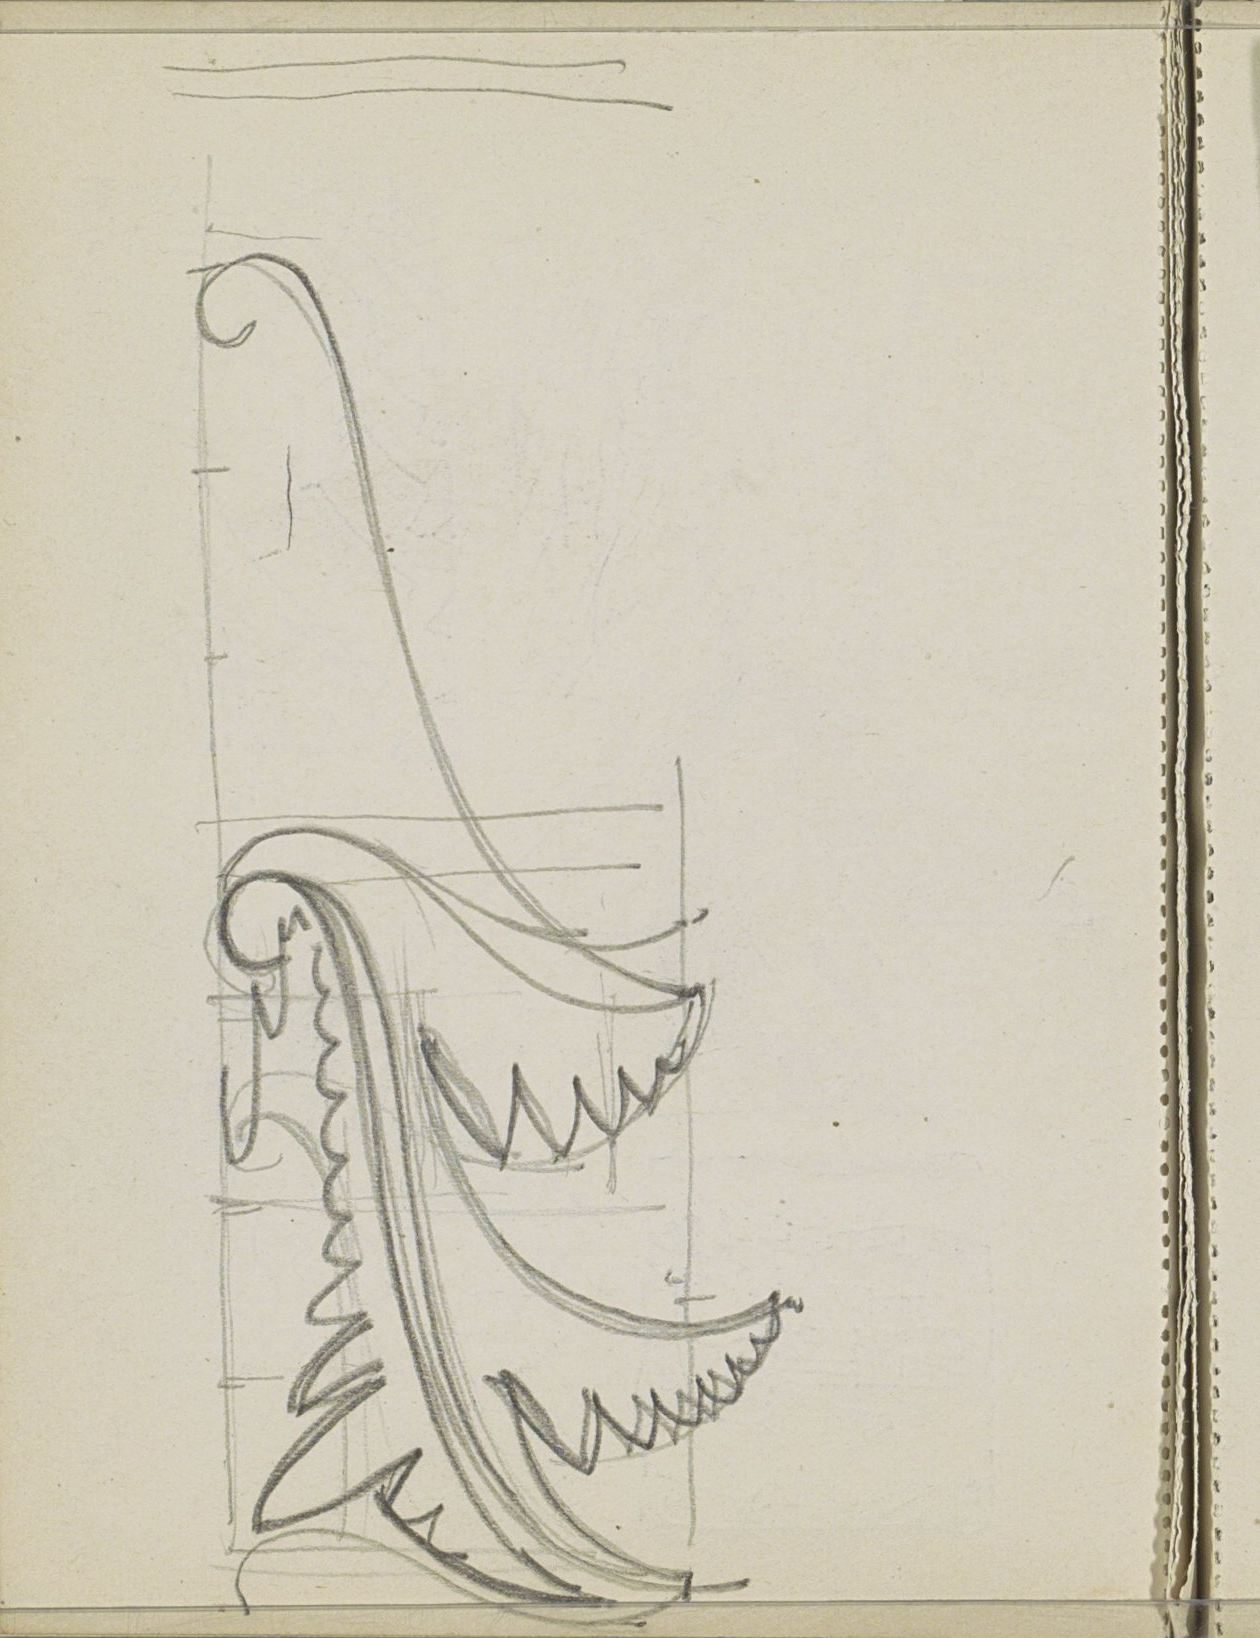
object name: sketchbook leaf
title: Ornament met bladmotief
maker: reijer stolk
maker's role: draughtsman, print maker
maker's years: 1896-1945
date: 1906-1945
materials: paper, pencil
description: Blad 46 verso uit een schetsboek met 53 bladen.